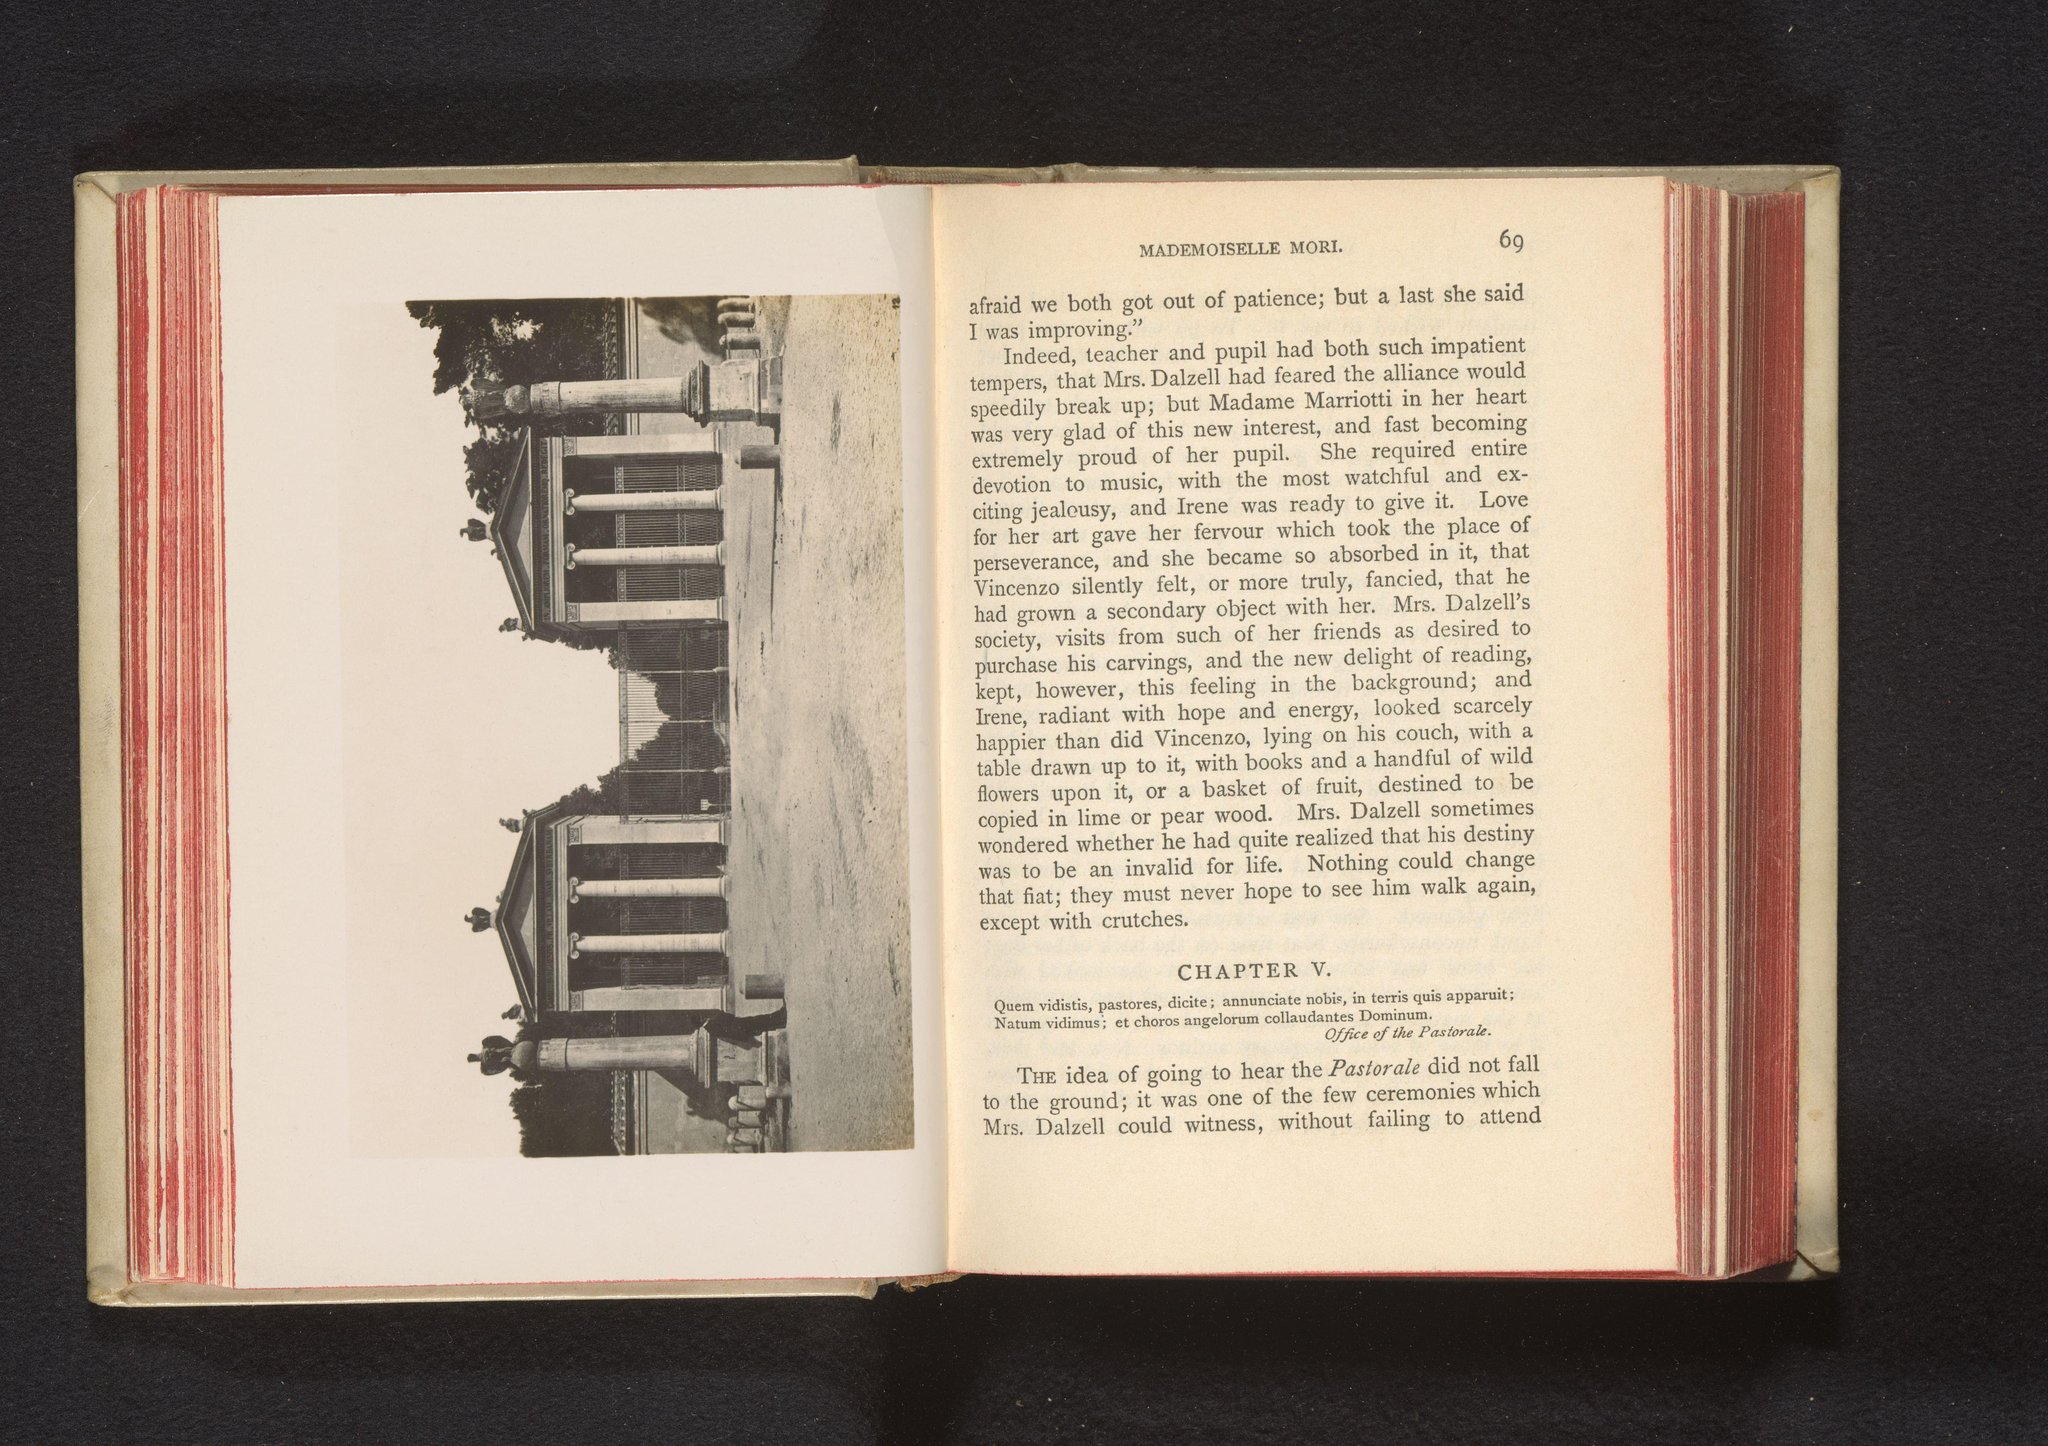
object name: page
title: Poorten van de tuinen van Villa Borghese te Rome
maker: Anonymous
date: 1852-1862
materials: photographic support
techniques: gelatin silver print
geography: rome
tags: garden, gate, entrance